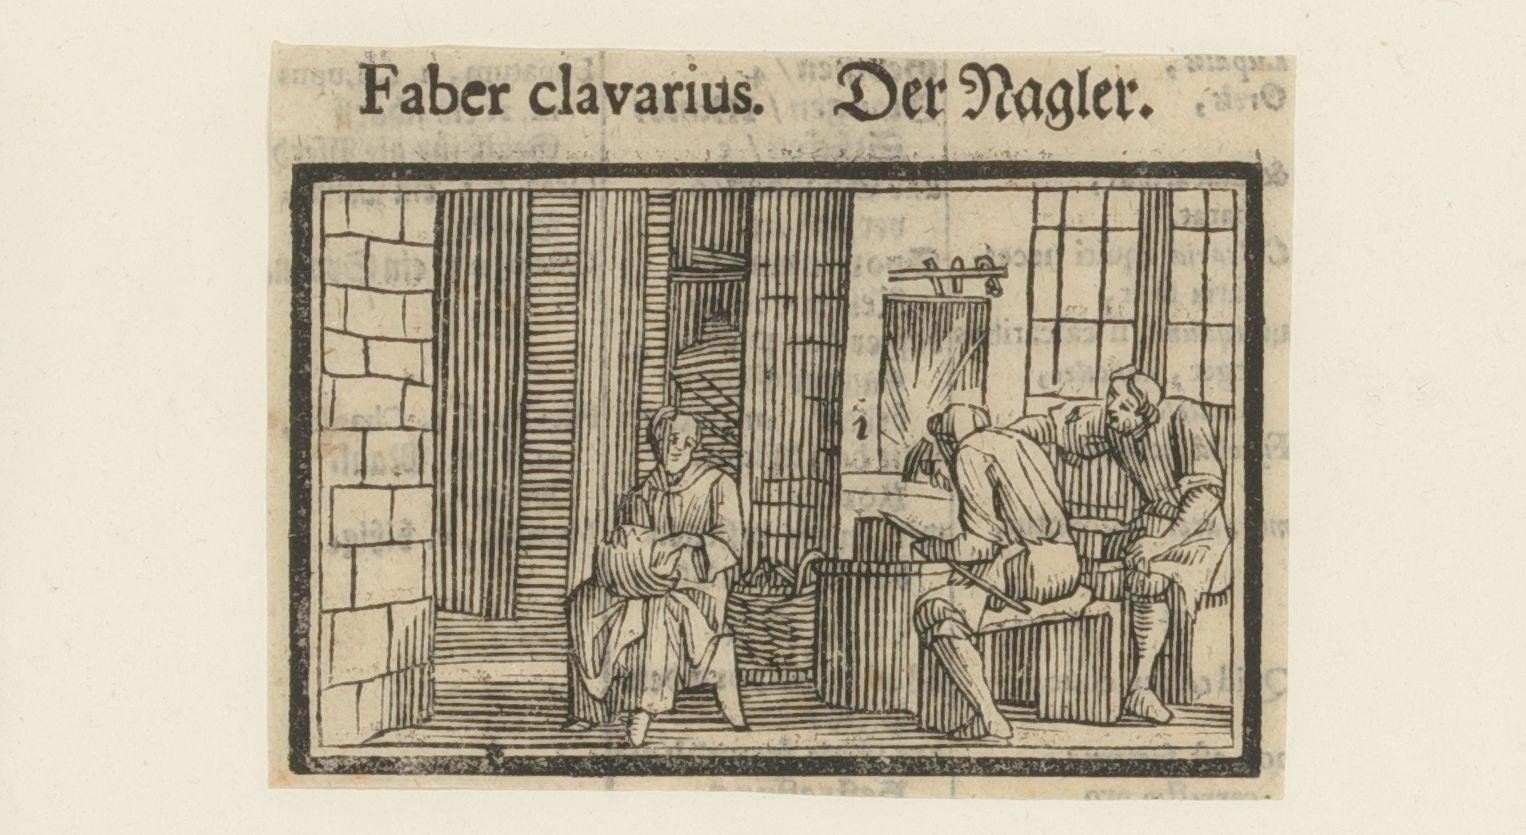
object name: print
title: Man smeedt een spijker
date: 1719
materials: paper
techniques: letterpress printing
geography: nuremberg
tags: tools, aids, implements ~ crafts and industries: nail, handicrafts, craftsman at work, smith, blacksmith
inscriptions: collector's mark: Lugt 1641, stamp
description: Prent uit: Comenius, Johannes Amosius. Orbis sensualium picti pars prima (...). Neurenberg: Martin Endter, 1719, dl. 2, p. 162. Prent eerder gebruikt in: Comenius, Johannes Amosius. Orbis Sensualium Picti denuo aucti Pars Secunda (...). Neurenberg: Martin Endter, 1730, dl. 2.